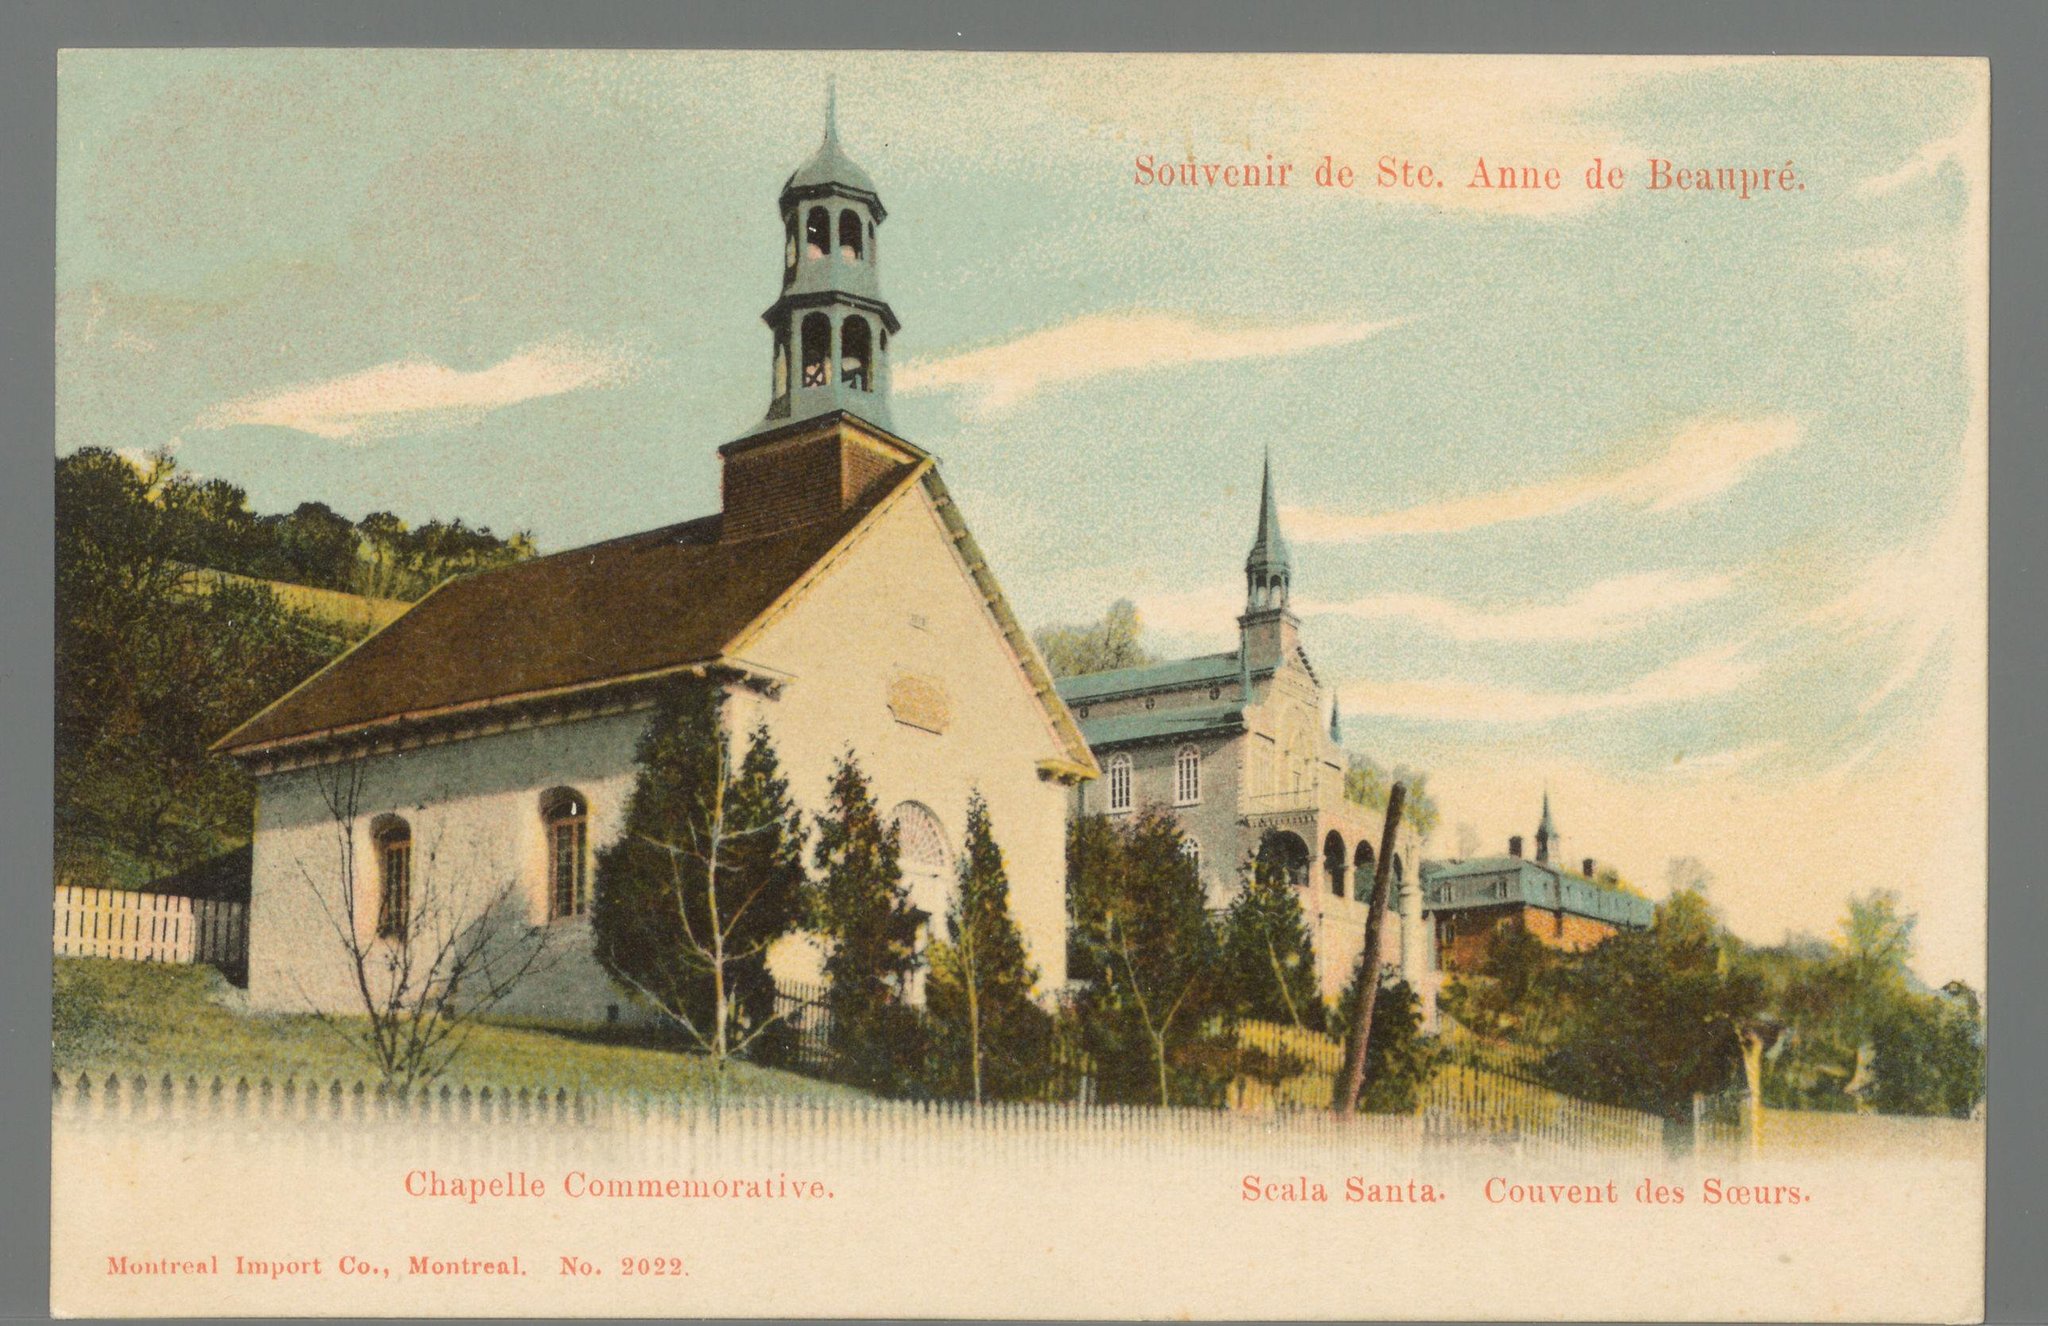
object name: ansichtkaart, prentbriefkaart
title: Souvenir de Ste. Anne de Beaupré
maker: Anonymous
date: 1903-1930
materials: cardboard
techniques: photograph, lithograph, writing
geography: sainte-anne-de-beaupré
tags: church (exterior)